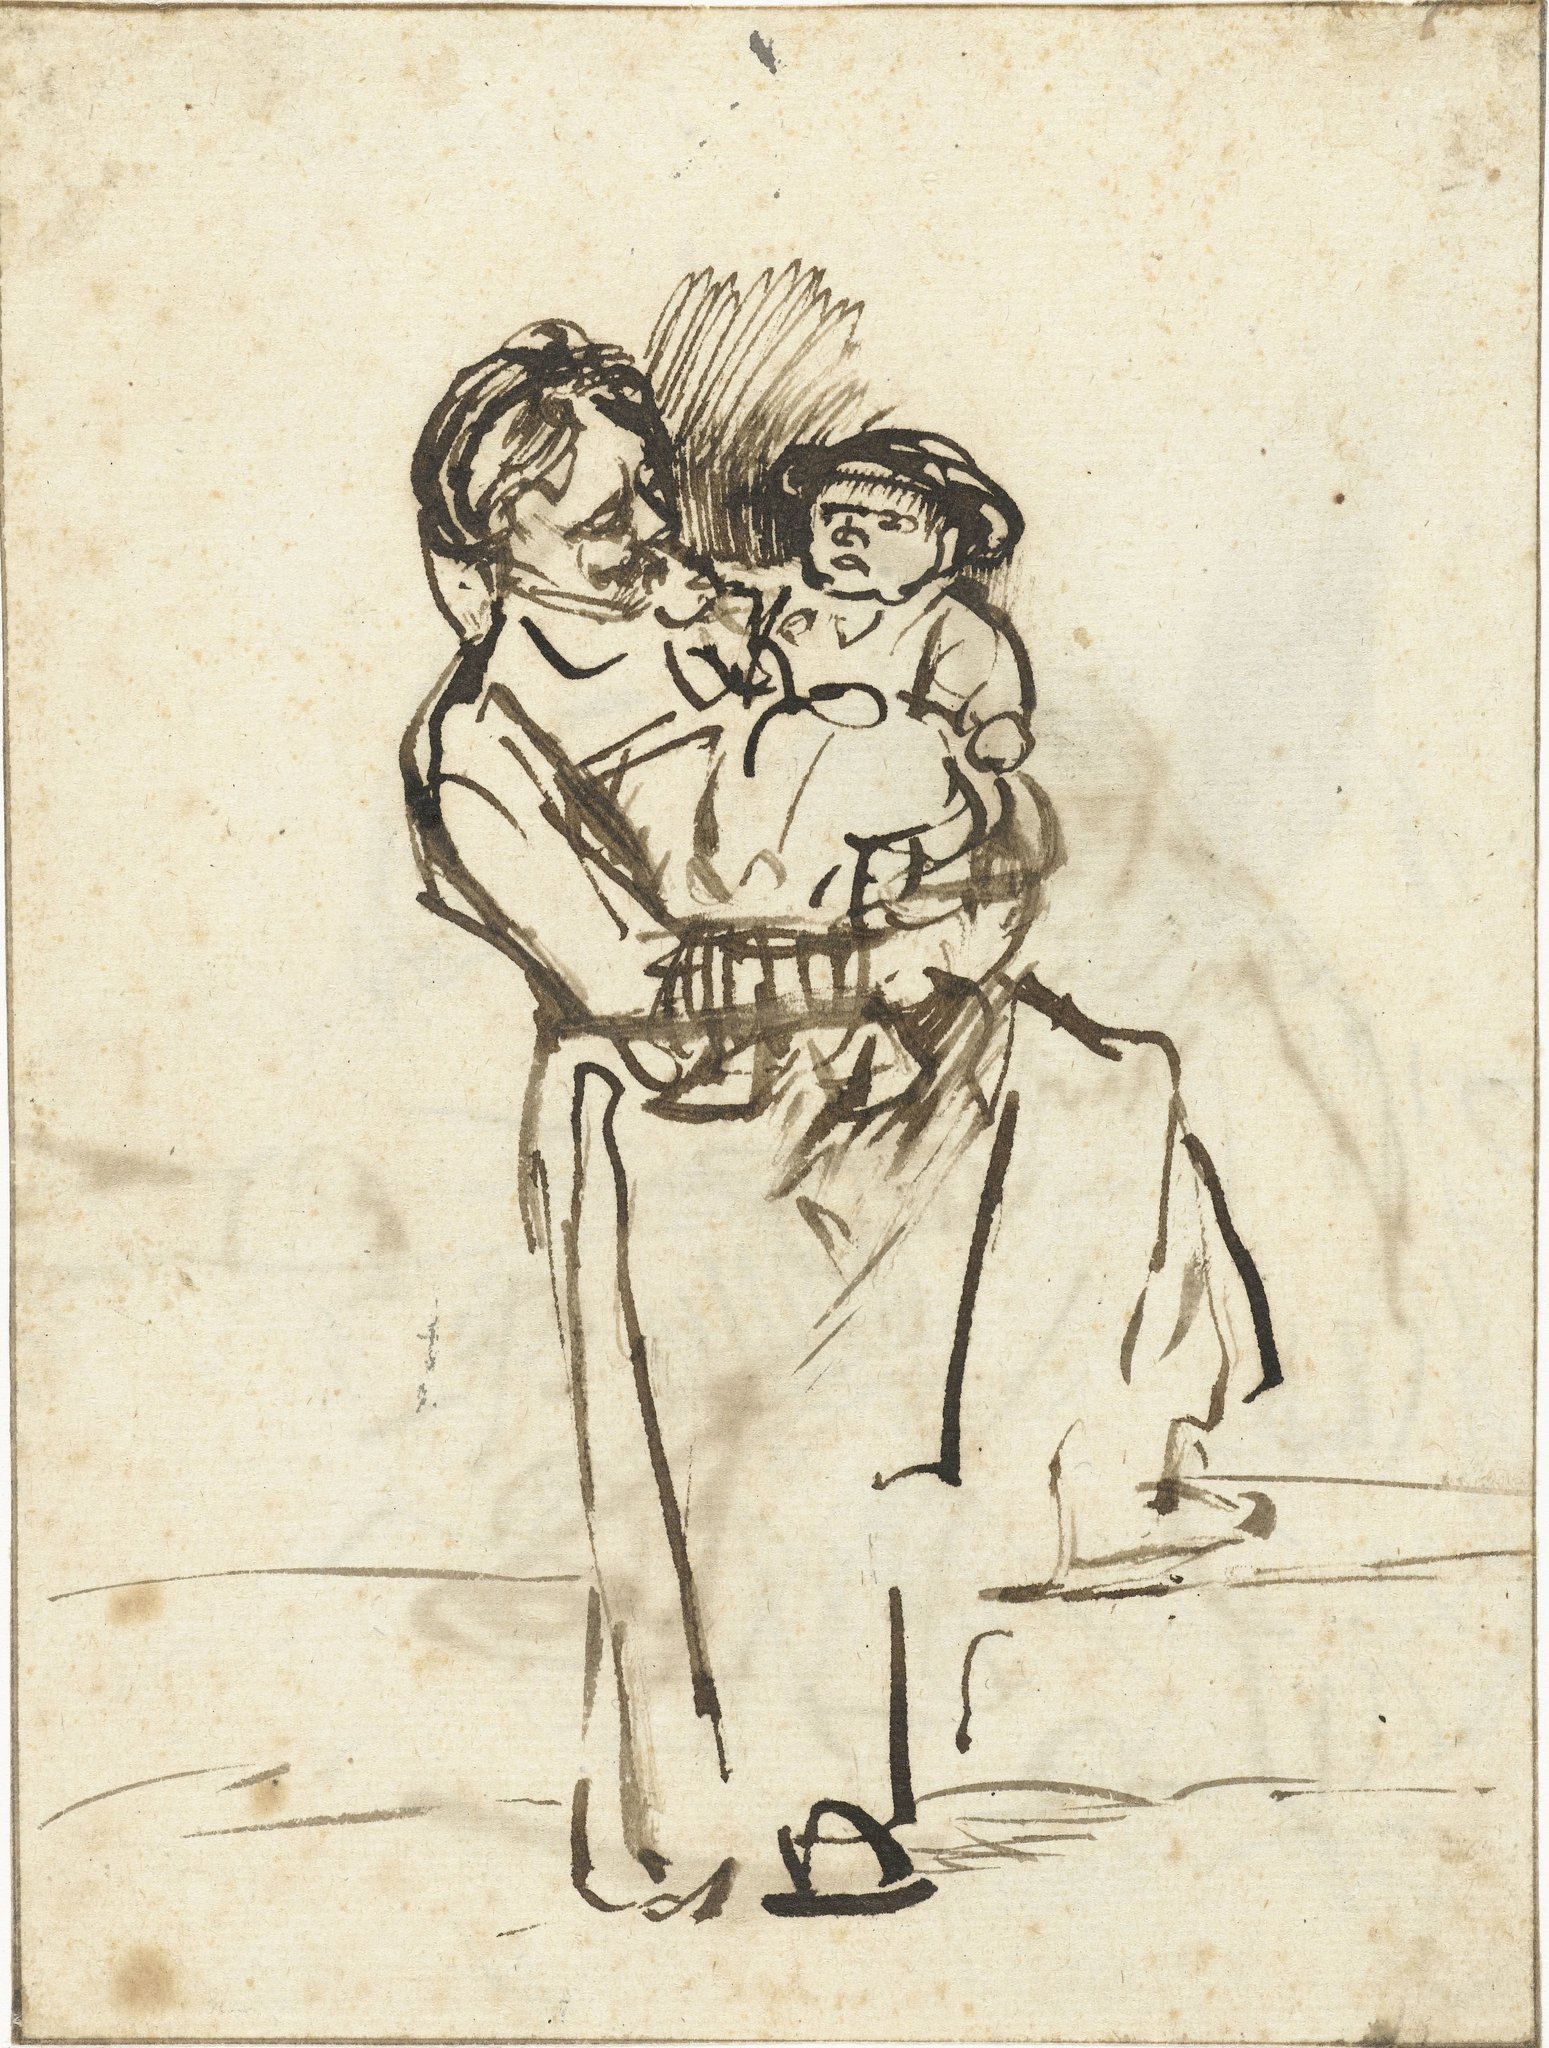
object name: drawing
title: Standing Woman Holding a Child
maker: jan victors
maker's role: painter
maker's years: 1619-1676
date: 1635-1638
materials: ink, paper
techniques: pen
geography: amsterdam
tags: mother and baby or young child